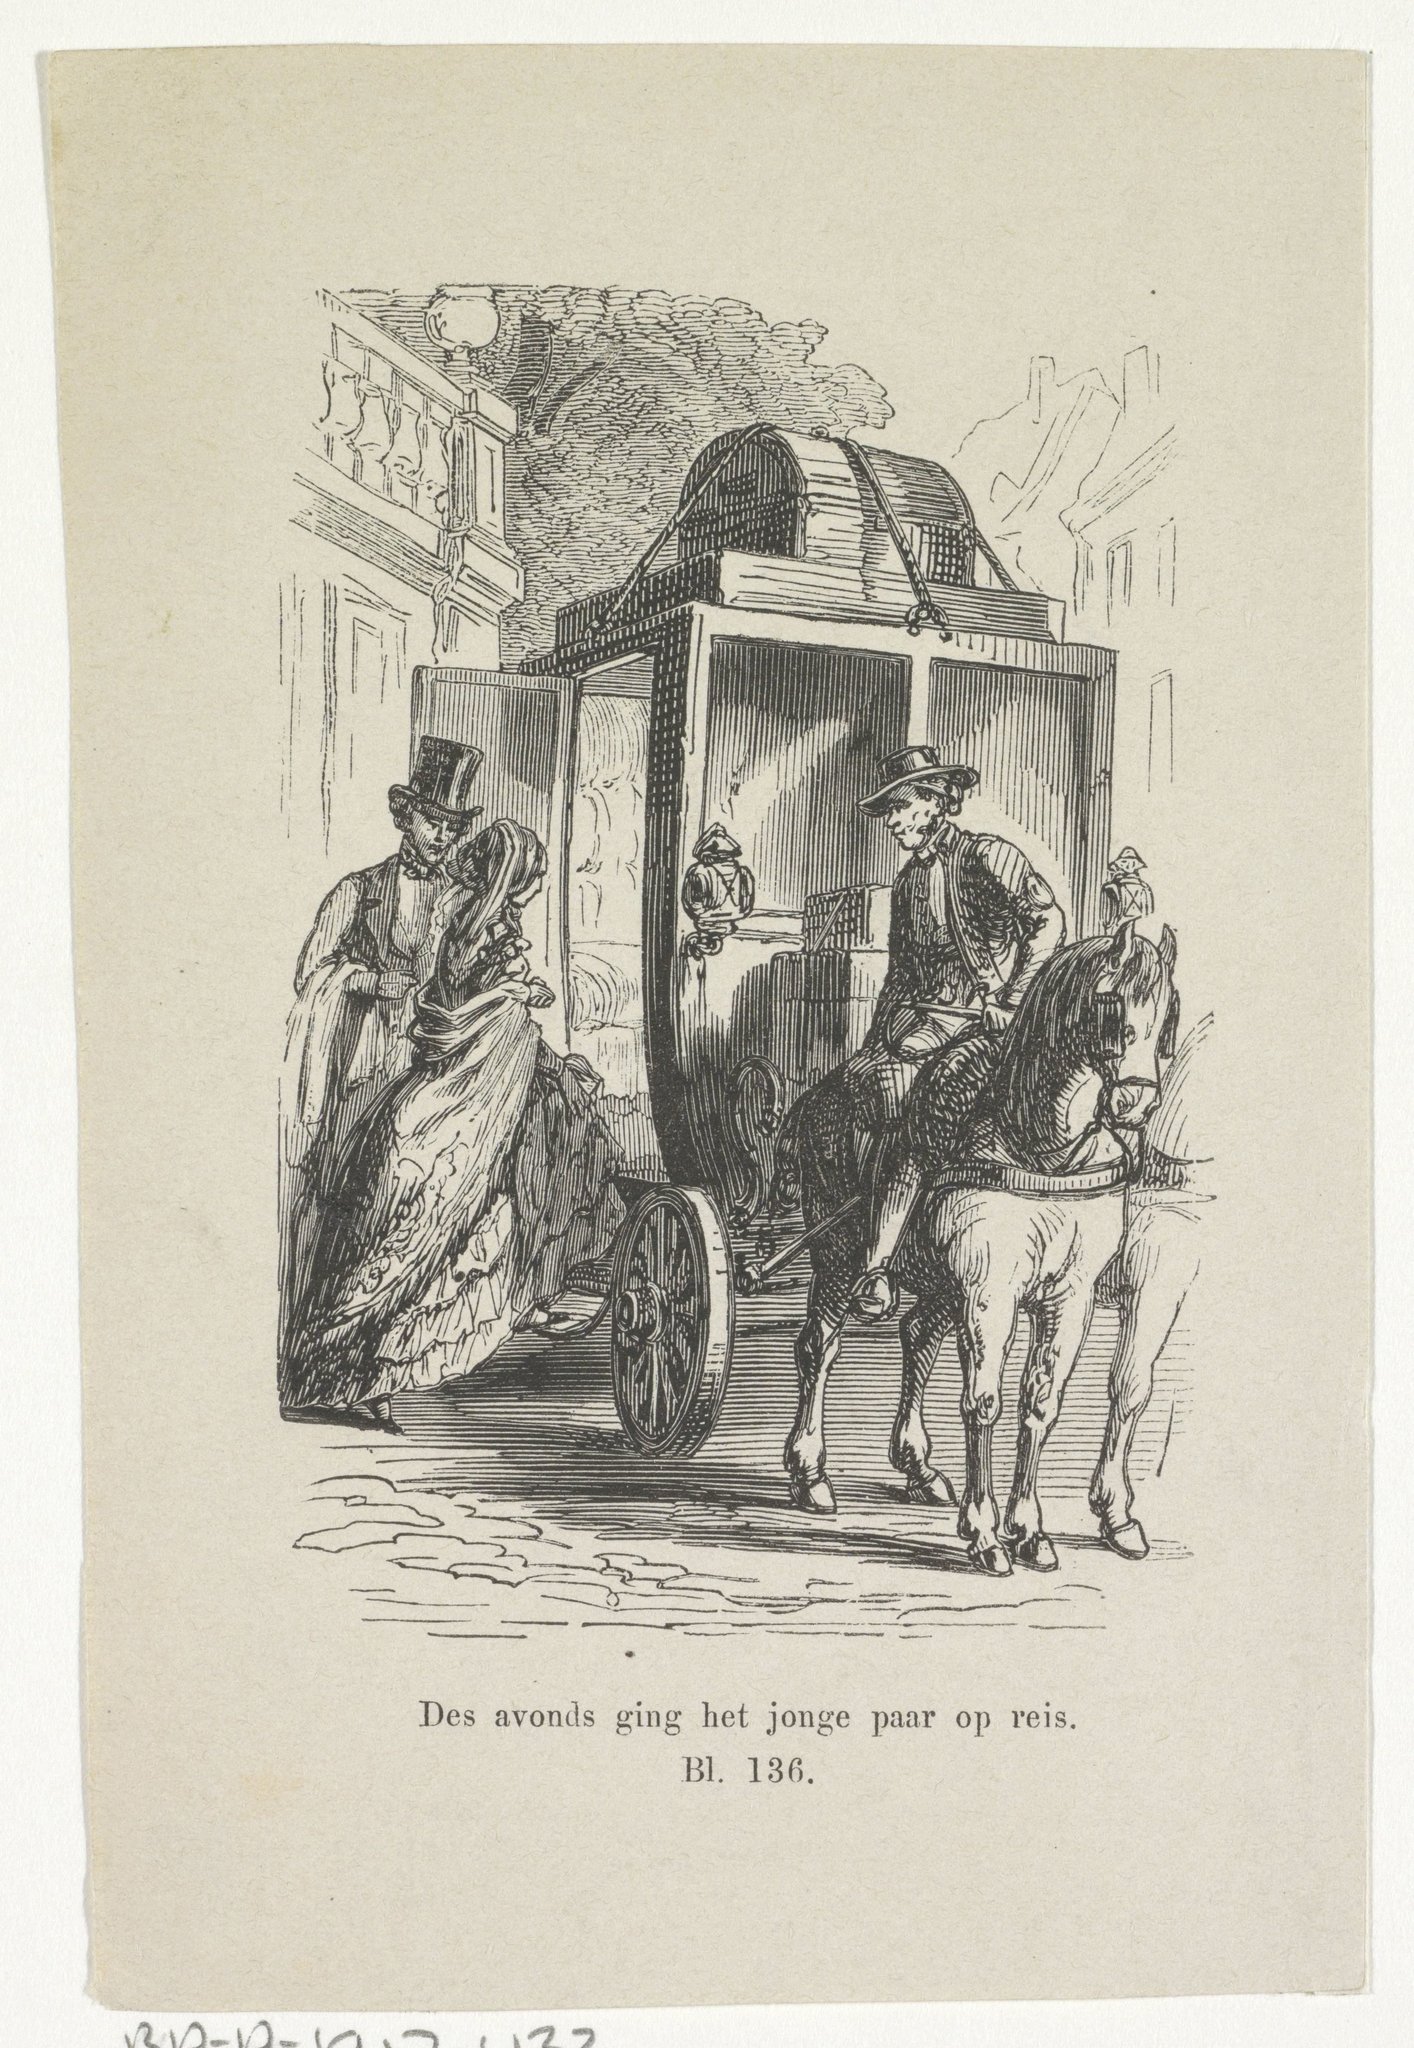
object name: print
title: Paar reizend met een koets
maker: rombertus julianus van arum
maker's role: print maker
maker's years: 1812-1883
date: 1822-1883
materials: paper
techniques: engraving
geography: amsterdam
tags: four-wheeled vehicle drawn by two animals, 'en route', traveller under way, trunk, suit-case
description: Een man en een vrouw stappen in een koets met twee paarden. Op de koets liggen meerdere koffers. In de ondermarge een regel Nederlandse tekst. Midden onder 'Bl. 136.'.